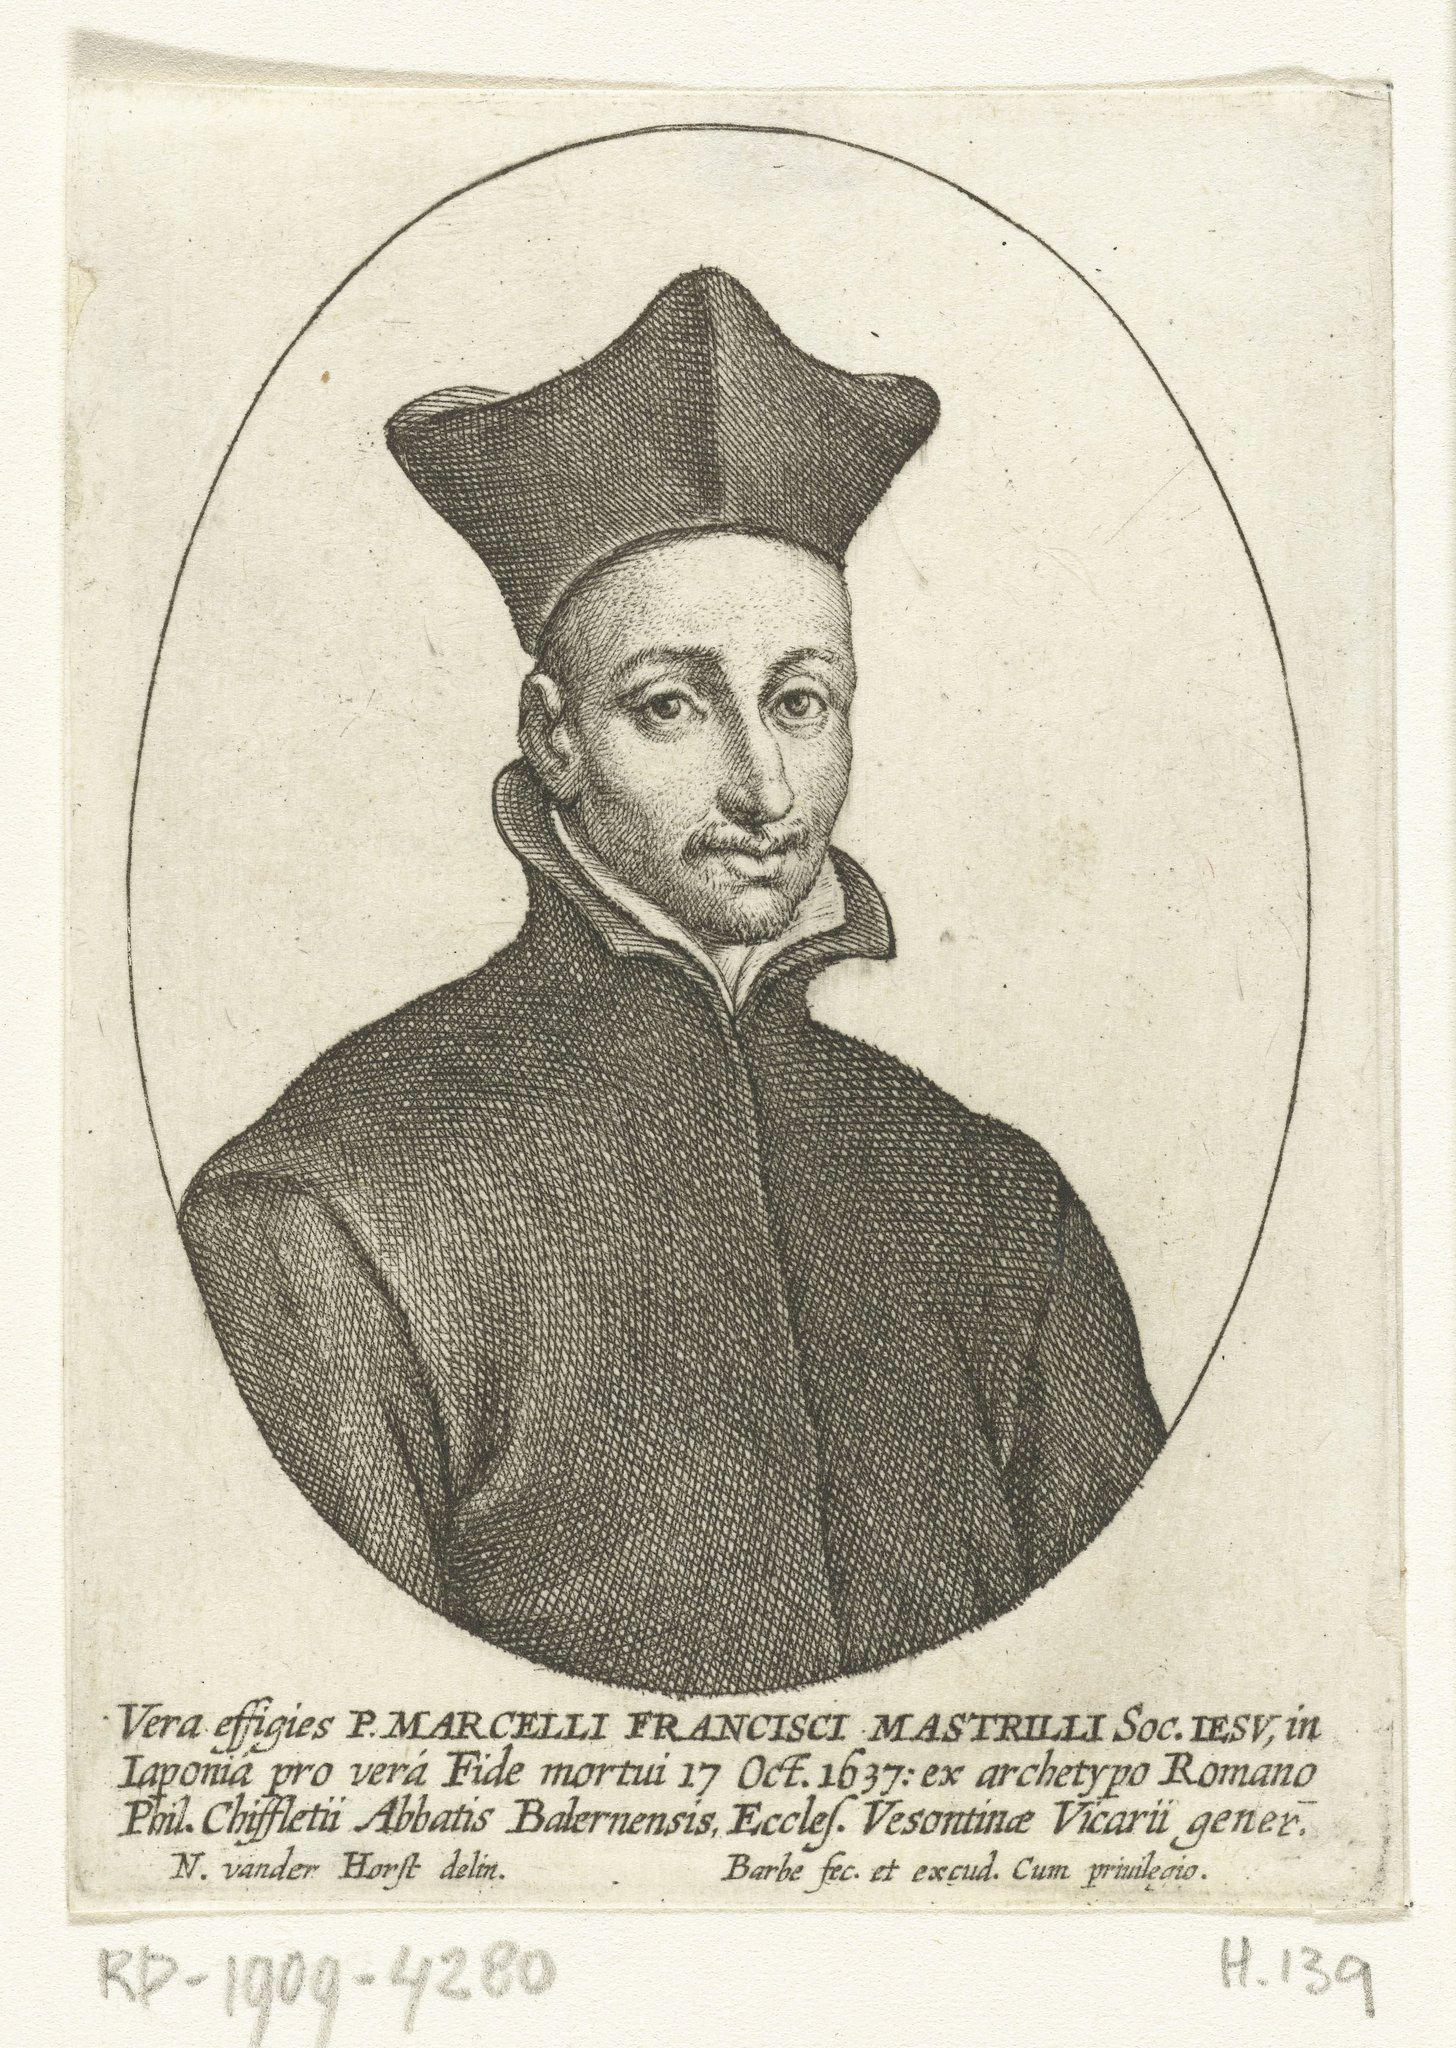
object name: print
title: Vera effigies P. Marcelli (...) Vesontinae Vicarii gener.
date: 1637-1649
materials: paper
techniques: engraving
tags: priest (roman catholic)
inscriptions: collector's mark: Lugt 2228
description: Prent naar tekening van Nicolaas van der Horst.